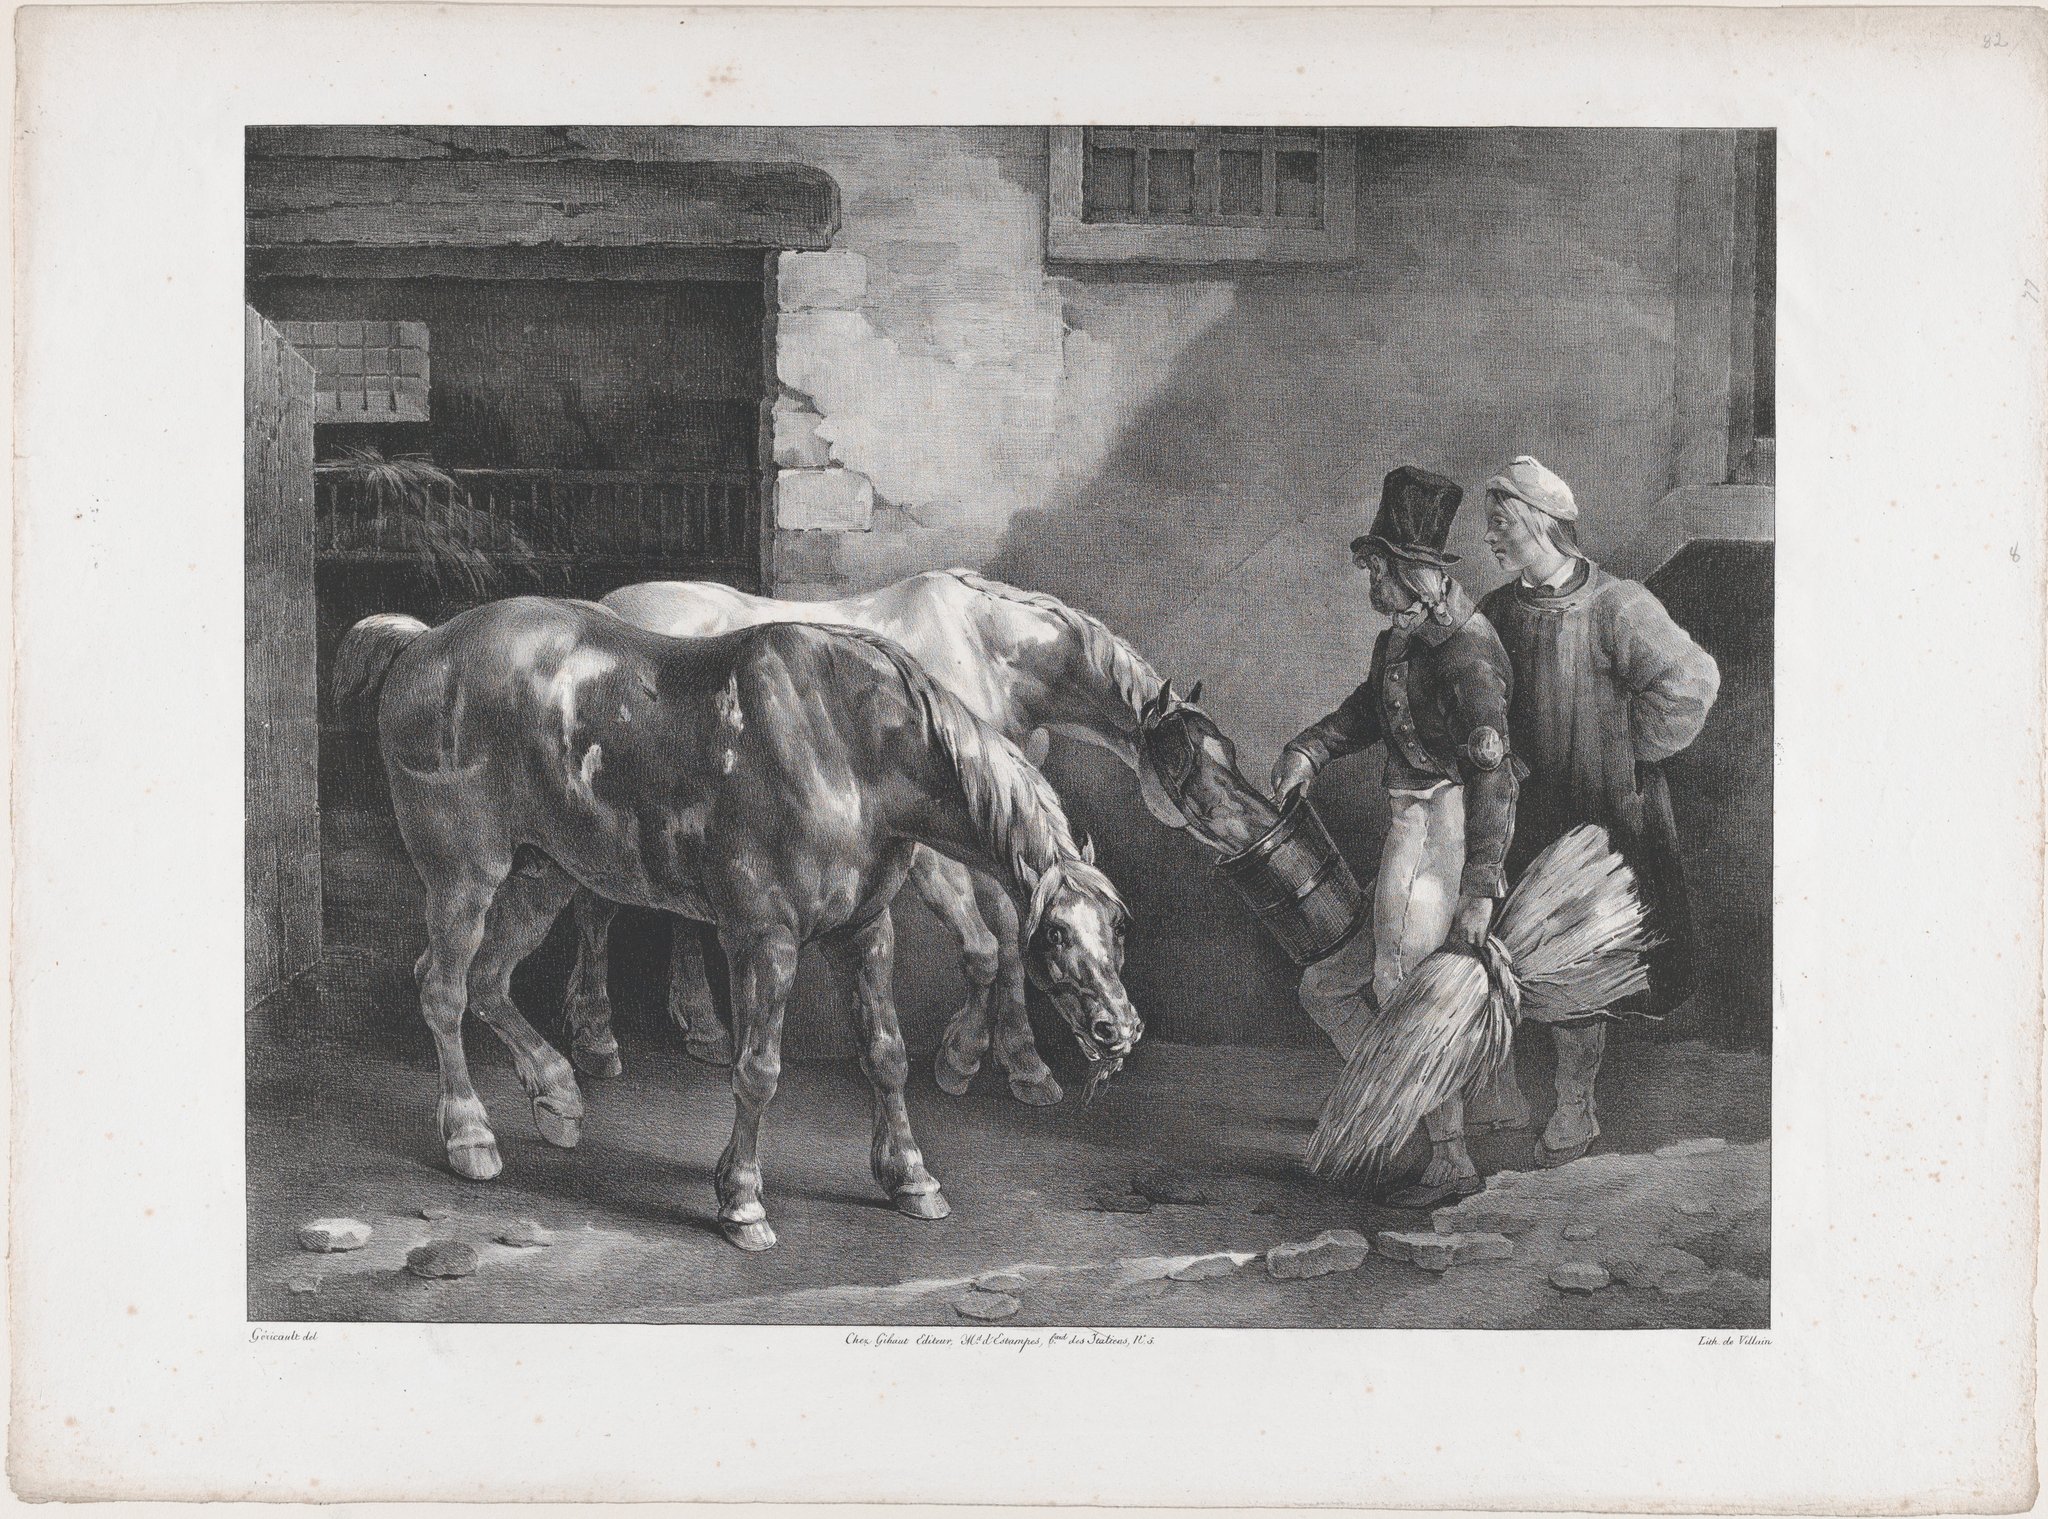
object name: print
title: Two Post Horses at the Door of a Stable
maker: jean louis andré théodore géricault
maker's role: artist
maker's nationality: french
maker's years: 1791-1824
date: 1822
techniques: lithograph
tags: men,horses